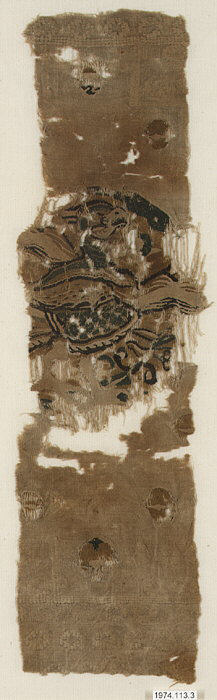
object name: textile fragment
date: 801-900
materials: linen, wool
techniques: tapestry, weave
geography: egypt